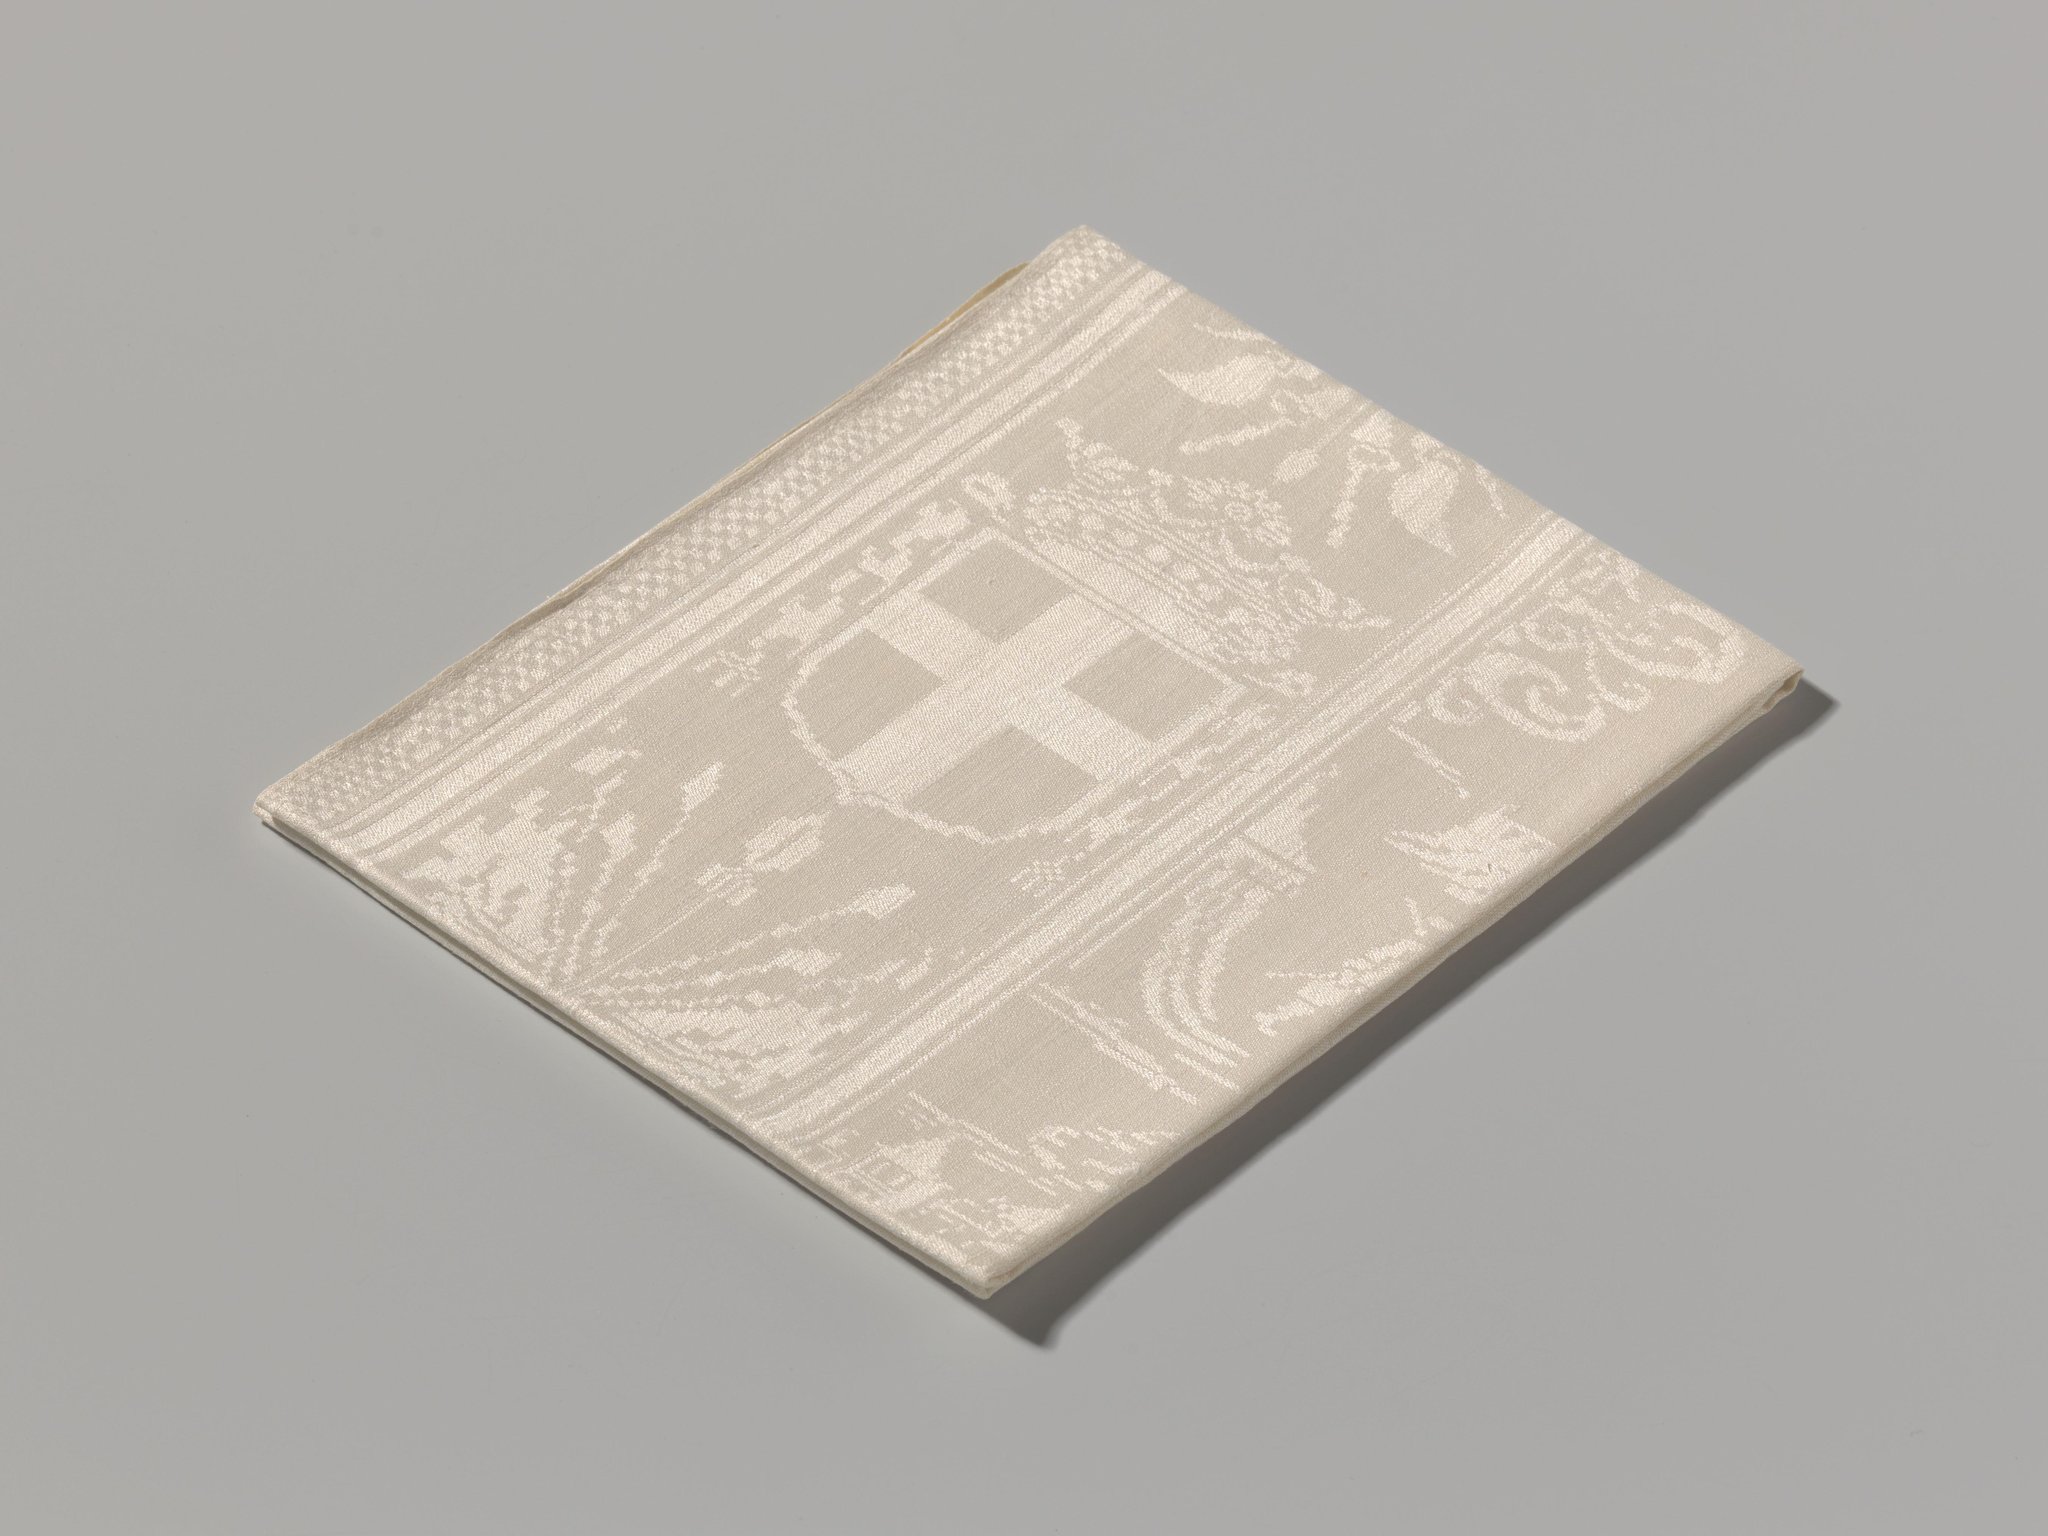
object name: napkin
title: Servet met het wapen van Karel III van Spanje en een gezicht op Rijssel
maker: Anonymous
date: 1702-1713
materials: linen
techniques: damask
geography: kortrijk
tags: vienna, charles vi (holy roman emperor), lille, spain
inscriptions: mark: ‘13’, mark: ‘? S’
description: Servet van linnendamast met het wapen van Karel III van Spanje en een gezicht op Rijssel. Het symmetrisch patroon vertoont van onder naar boven de volgende taferelen: 1 Een gezicht op Rijssel met vele torens. 2 Plattegrond van een vesting met bovenschrift LILLE. 3 Ruiter te paard (Karel III van Spanje?). 4 Het wapen van Karel III van Spanje geflankeerd door vaandels. Staande en liggende randen: wapens, onder andere Savoye, en wapentrofeeën; daarbuiten: blokkenrand.